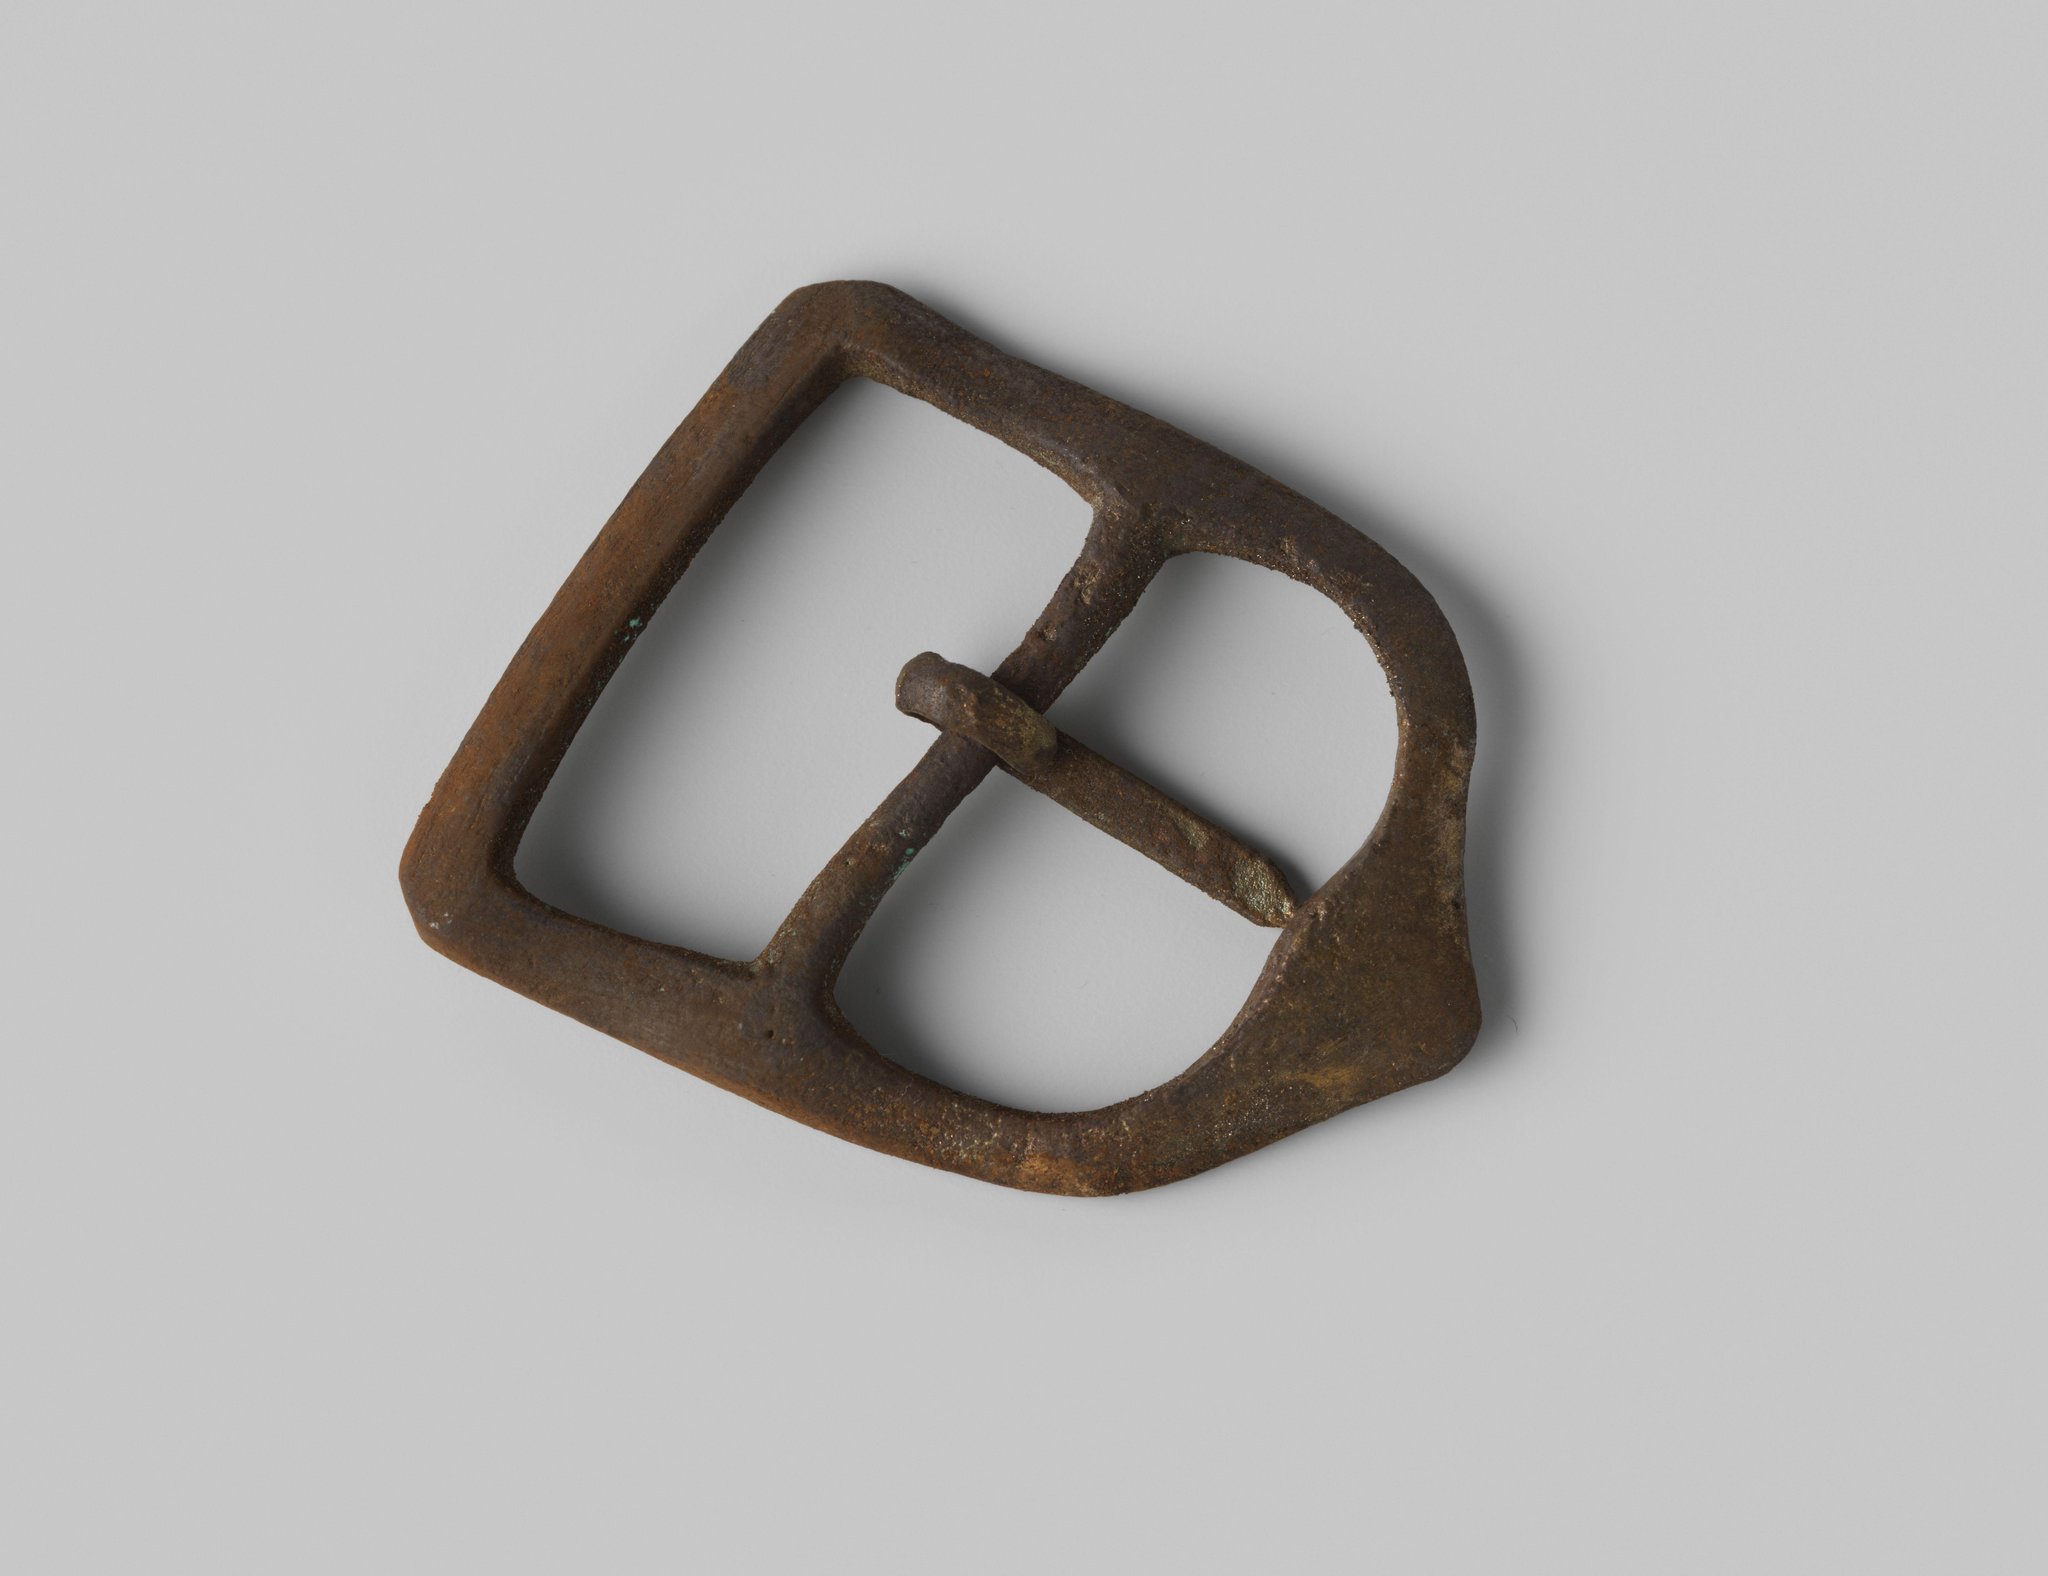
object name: belt buckle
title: Riemgesp uit het wrak de Oost-Indiëvaarder Hollandia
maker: Anonymous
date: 1700-1743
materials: copper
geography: netherlands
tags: verenigde oostindische compagnie, hollandia (schip), annet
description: Belt buckle. d-shaped with pointed side, id. NG 1980-27H384.